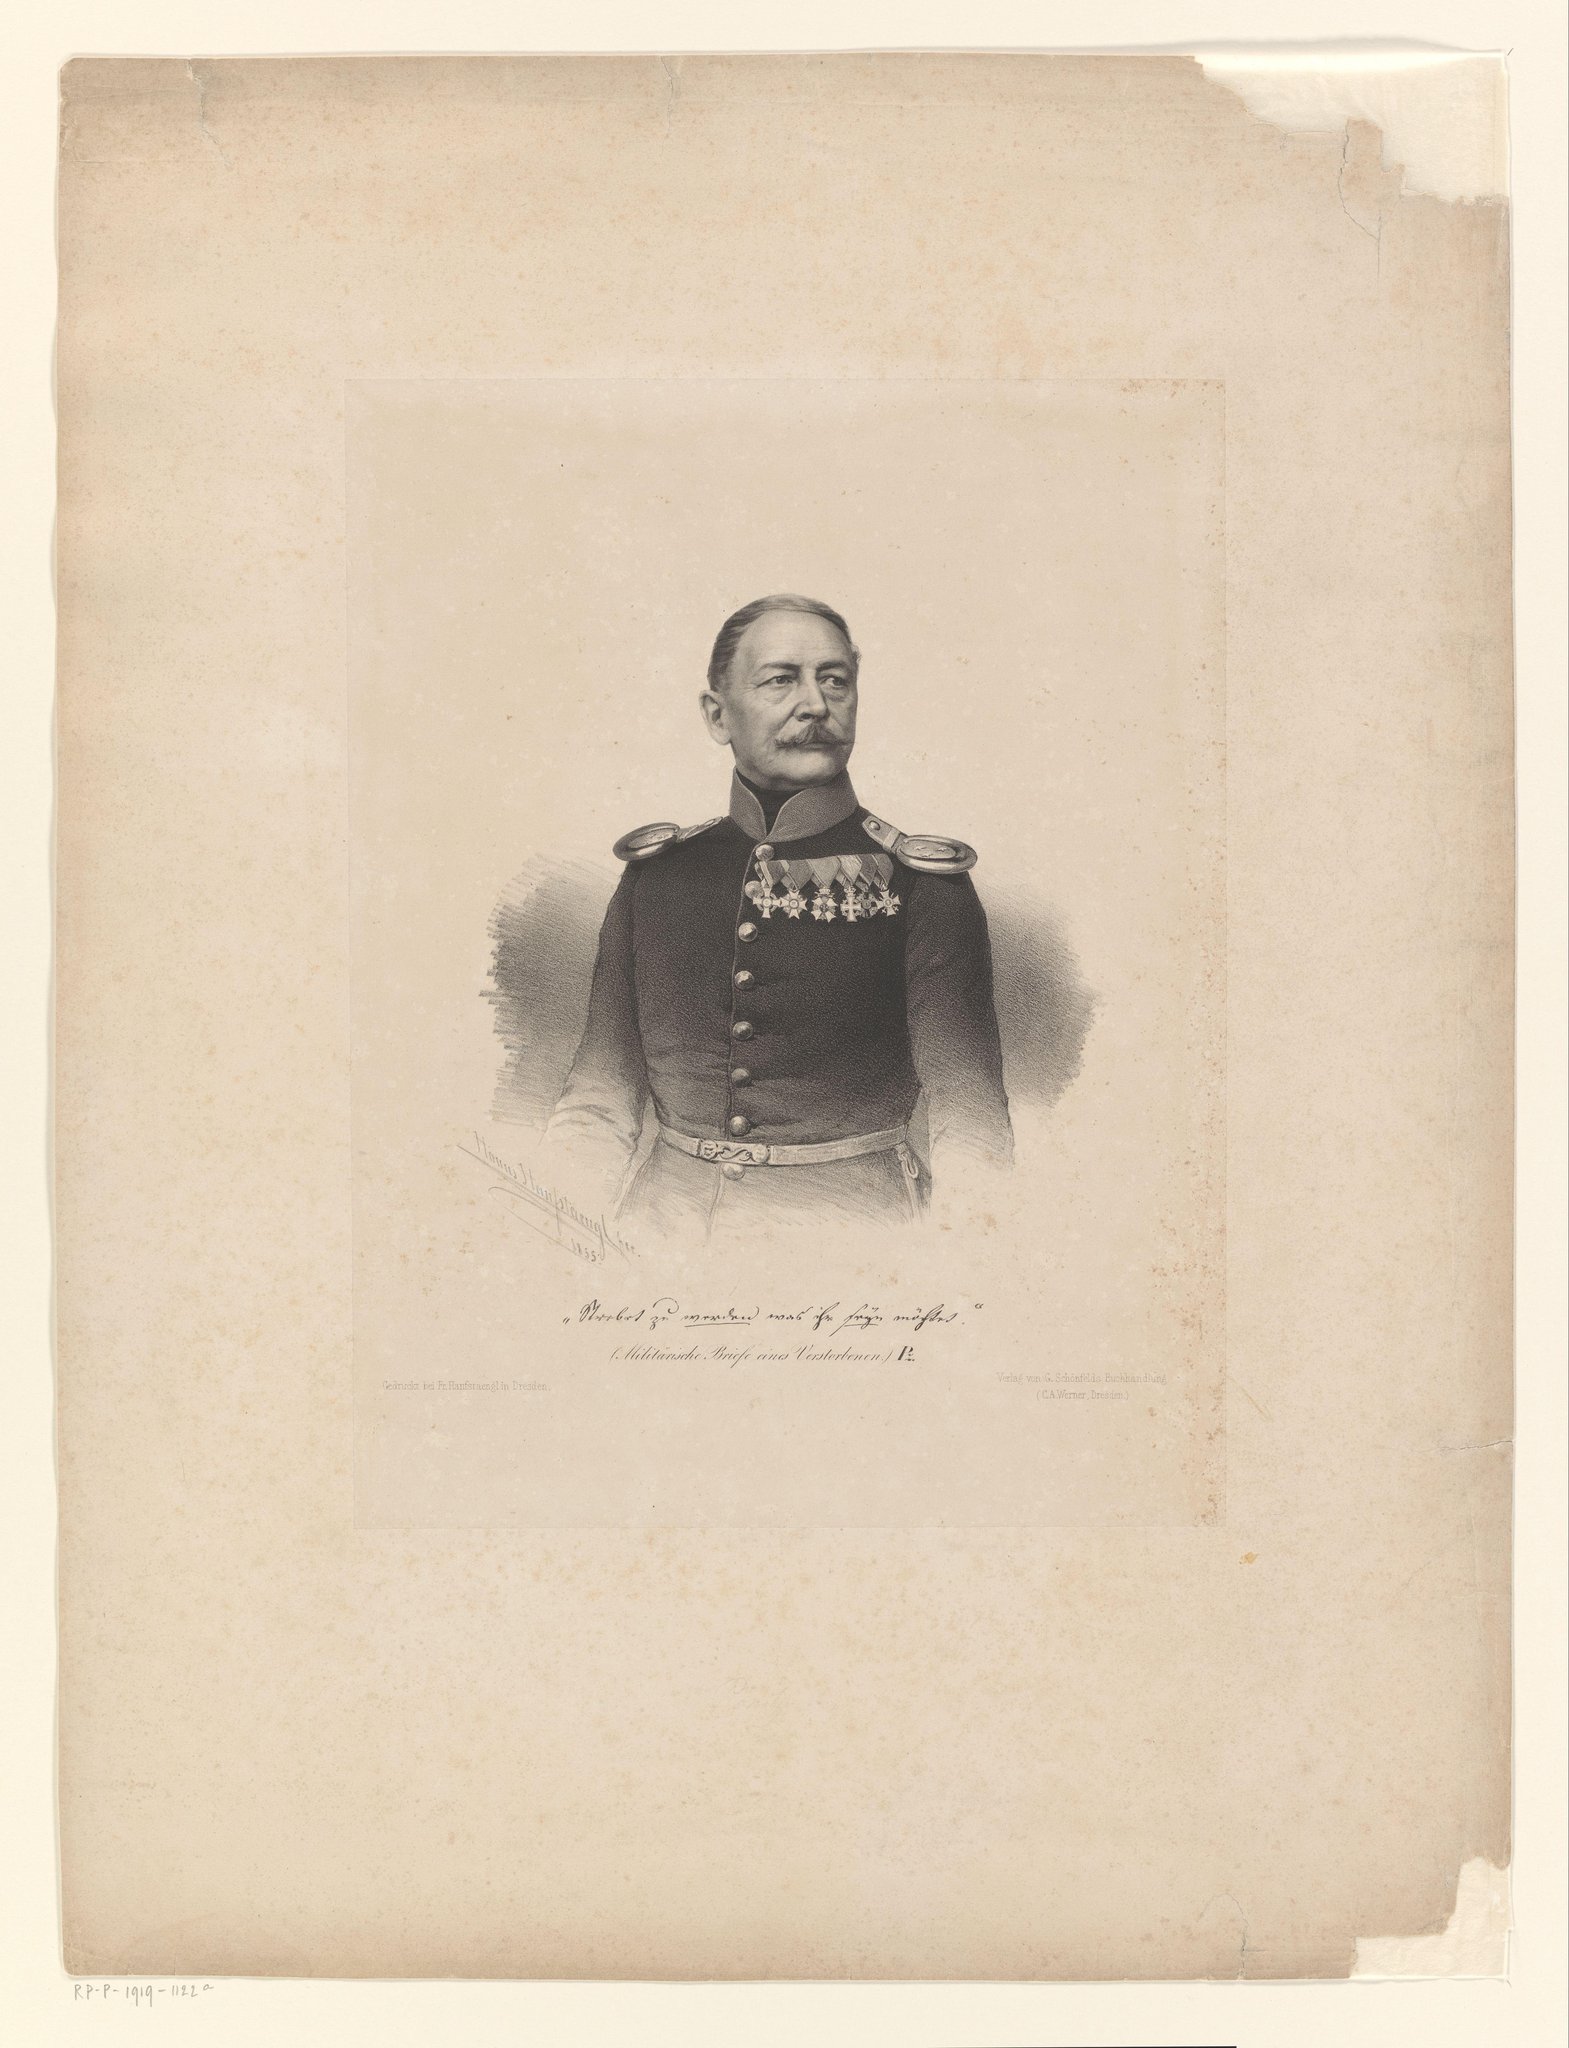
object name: print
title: Portret van Carl Eduard Pönitz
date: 1855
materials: paper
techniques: lithograph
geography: dresden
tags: moustache, adult man, historical persons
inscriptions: collector's mark: Lugt 2228